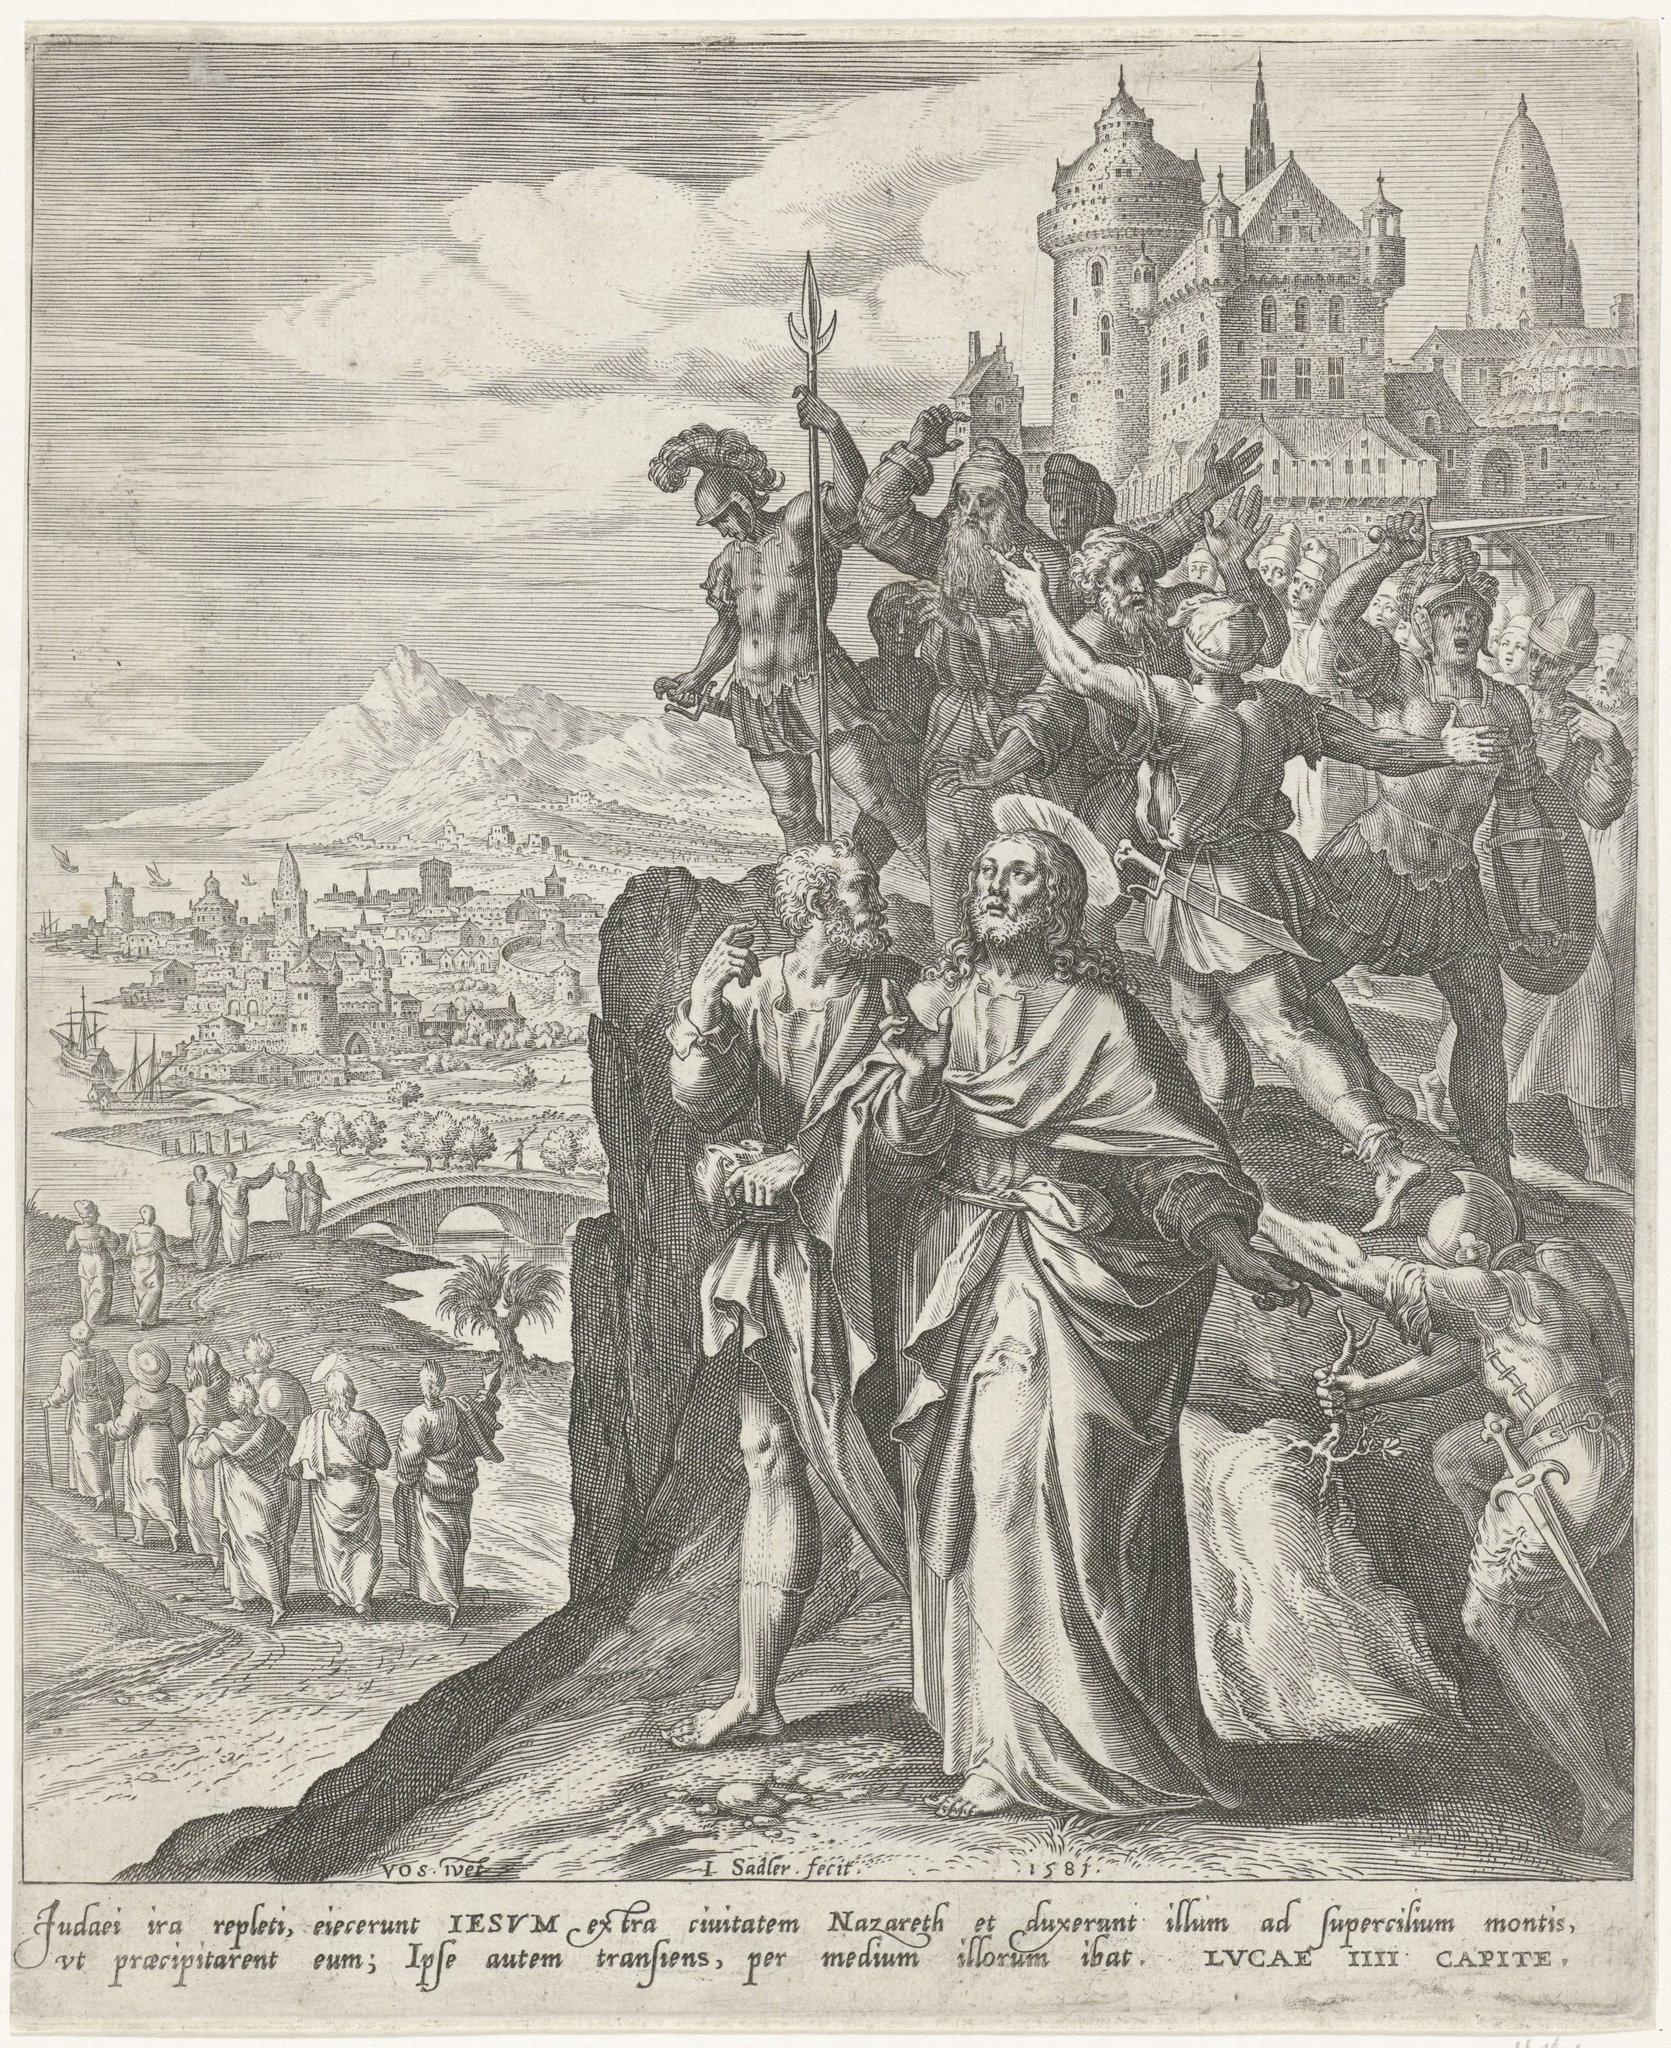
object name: print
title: Inwoners van Nazareth verdrijven Christus uit de stad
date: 1581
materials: paper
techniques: engraving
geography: cologne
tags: christ, having been chased out of nazareth, passes unharmed through the multitude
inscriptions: collector's mark: Lugt 2228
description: Op de voorgrond een ravijn met Christus naast Petrus. Rechts op het tweede plan de inwoners van Nazareth die Christus uitjouwen en uit hun stad drijven. Op de achtergrond links zet Christus zijn reis door Israël voort. De prent heeft een Latijns onderschrift met een Bijbeltekst (Luc. 4) en is de derde prent van een serie van vier.